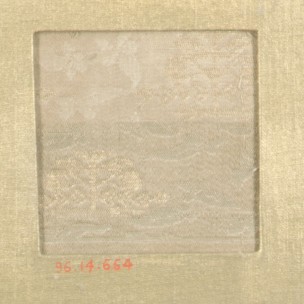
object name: piece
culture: japanese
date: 1701-1900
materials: silk